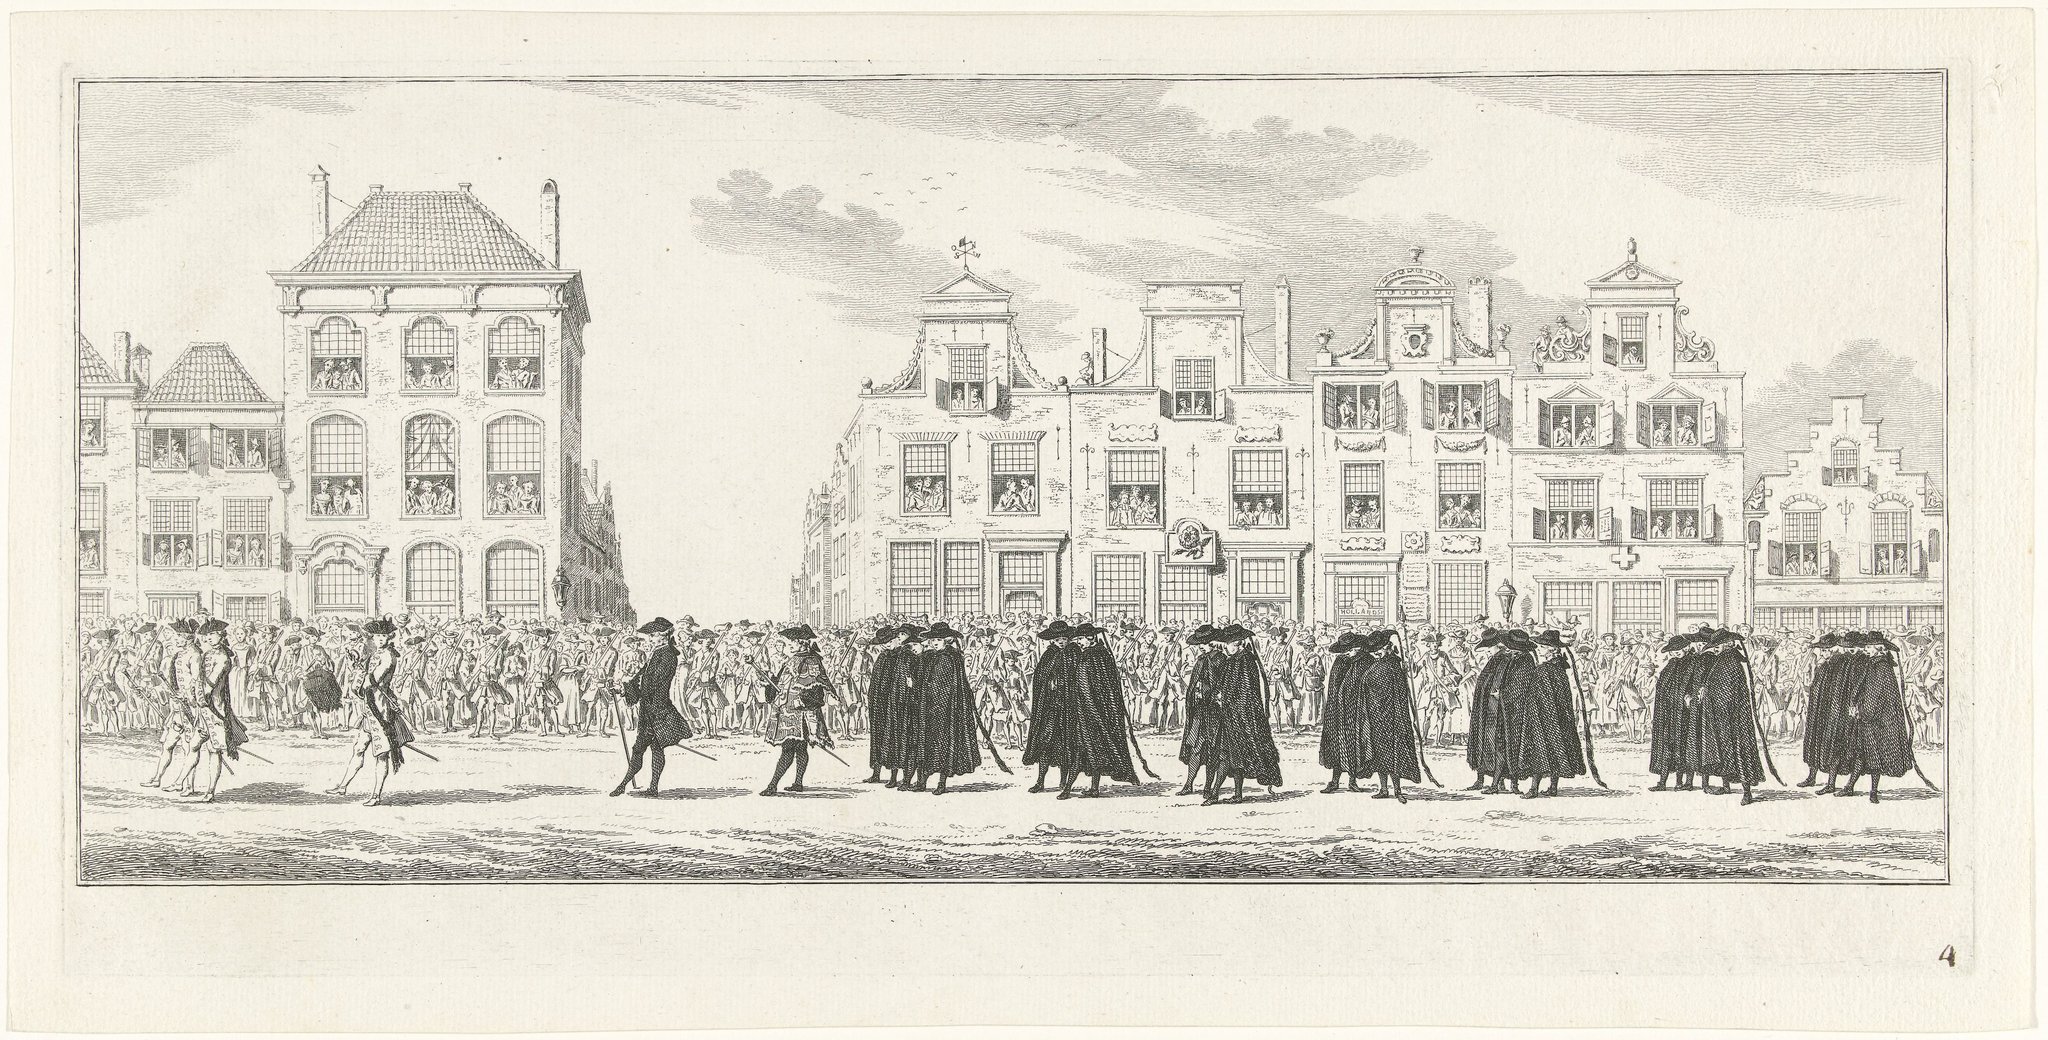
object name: print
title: Lijkstoet van prinses Anna van Hannover te Delft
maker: simon fokke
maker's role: draughtsman, print maker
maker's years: 1712-1784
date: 1759-1761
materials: paper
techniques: etching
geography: amsterdam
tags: the hague, anna van hannover, cortege, funeral procession, delft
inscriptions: collector's mark: Lugt 2228, serial number: ‘4’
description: De Cent-Suisses en leden van de stadhouderlijke hofhouding. Onderdeel van een serie van 16 platen in etsdruk van de lijkstatie van de op 23 februari 1759 te Delft begraven prinses Anna van Hannover.